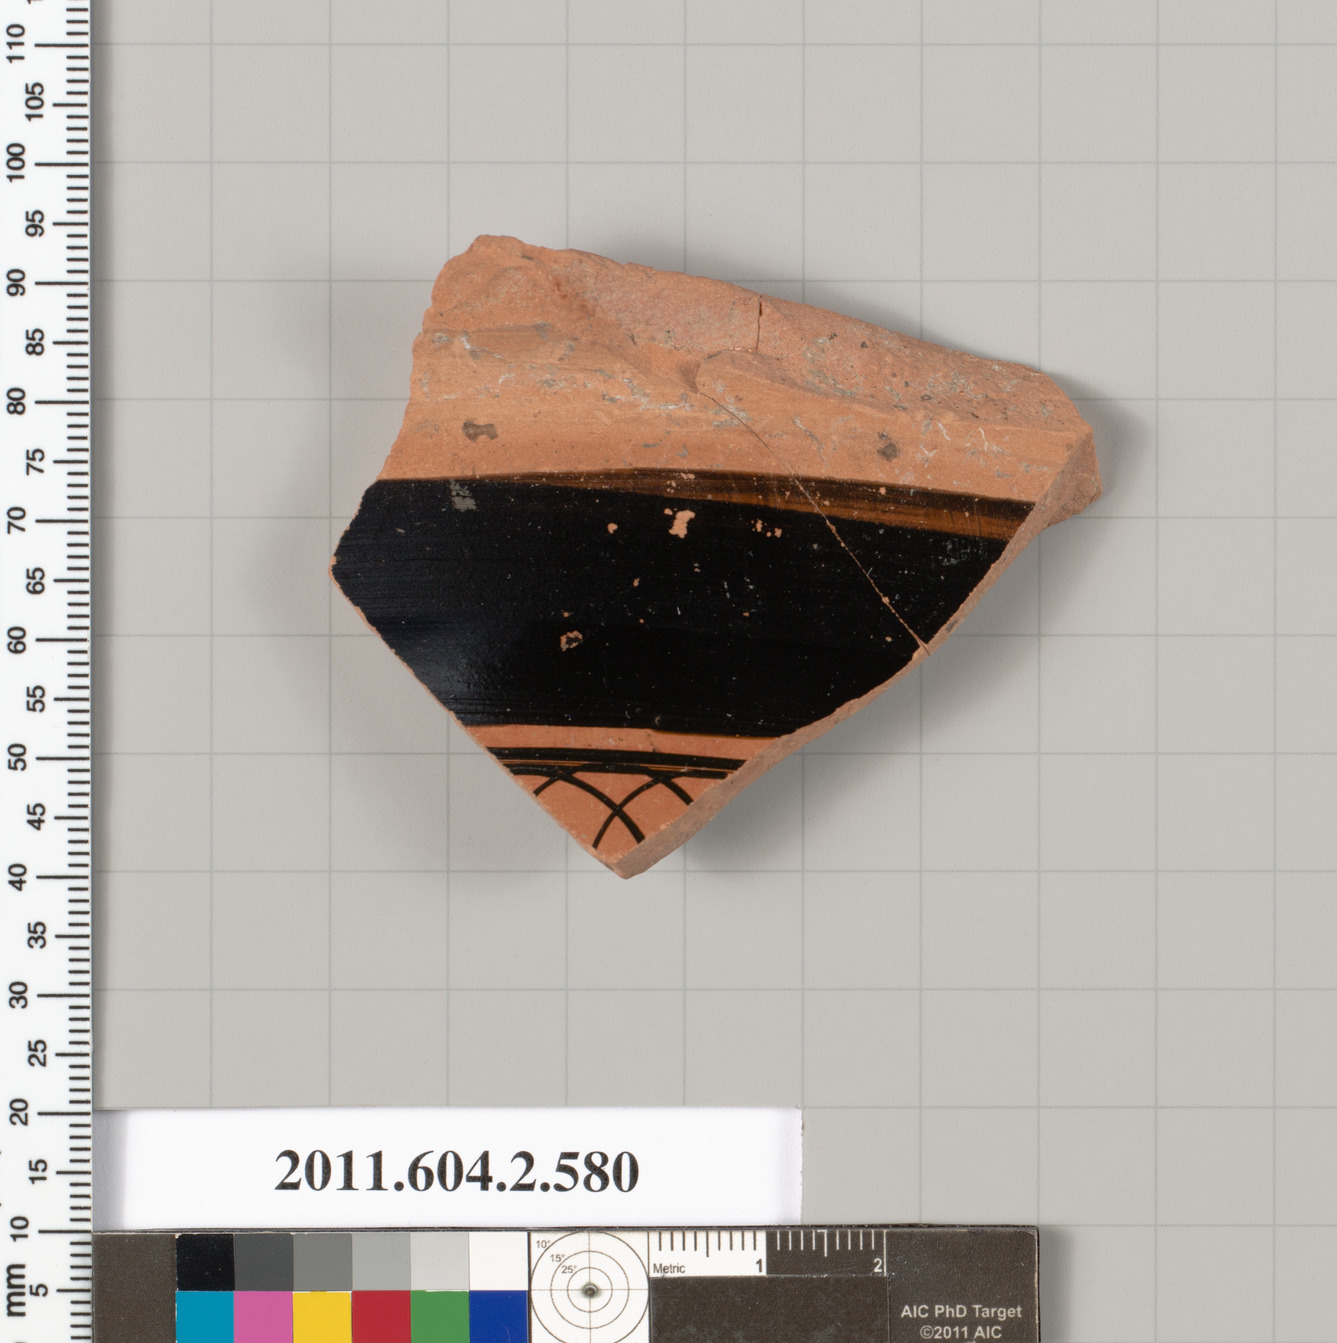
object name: column krater fragment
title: Terracotta fragment of a column-krater (bowl for mixing wine and water)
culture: greek, attic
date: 460-440 BCE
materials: terracotta